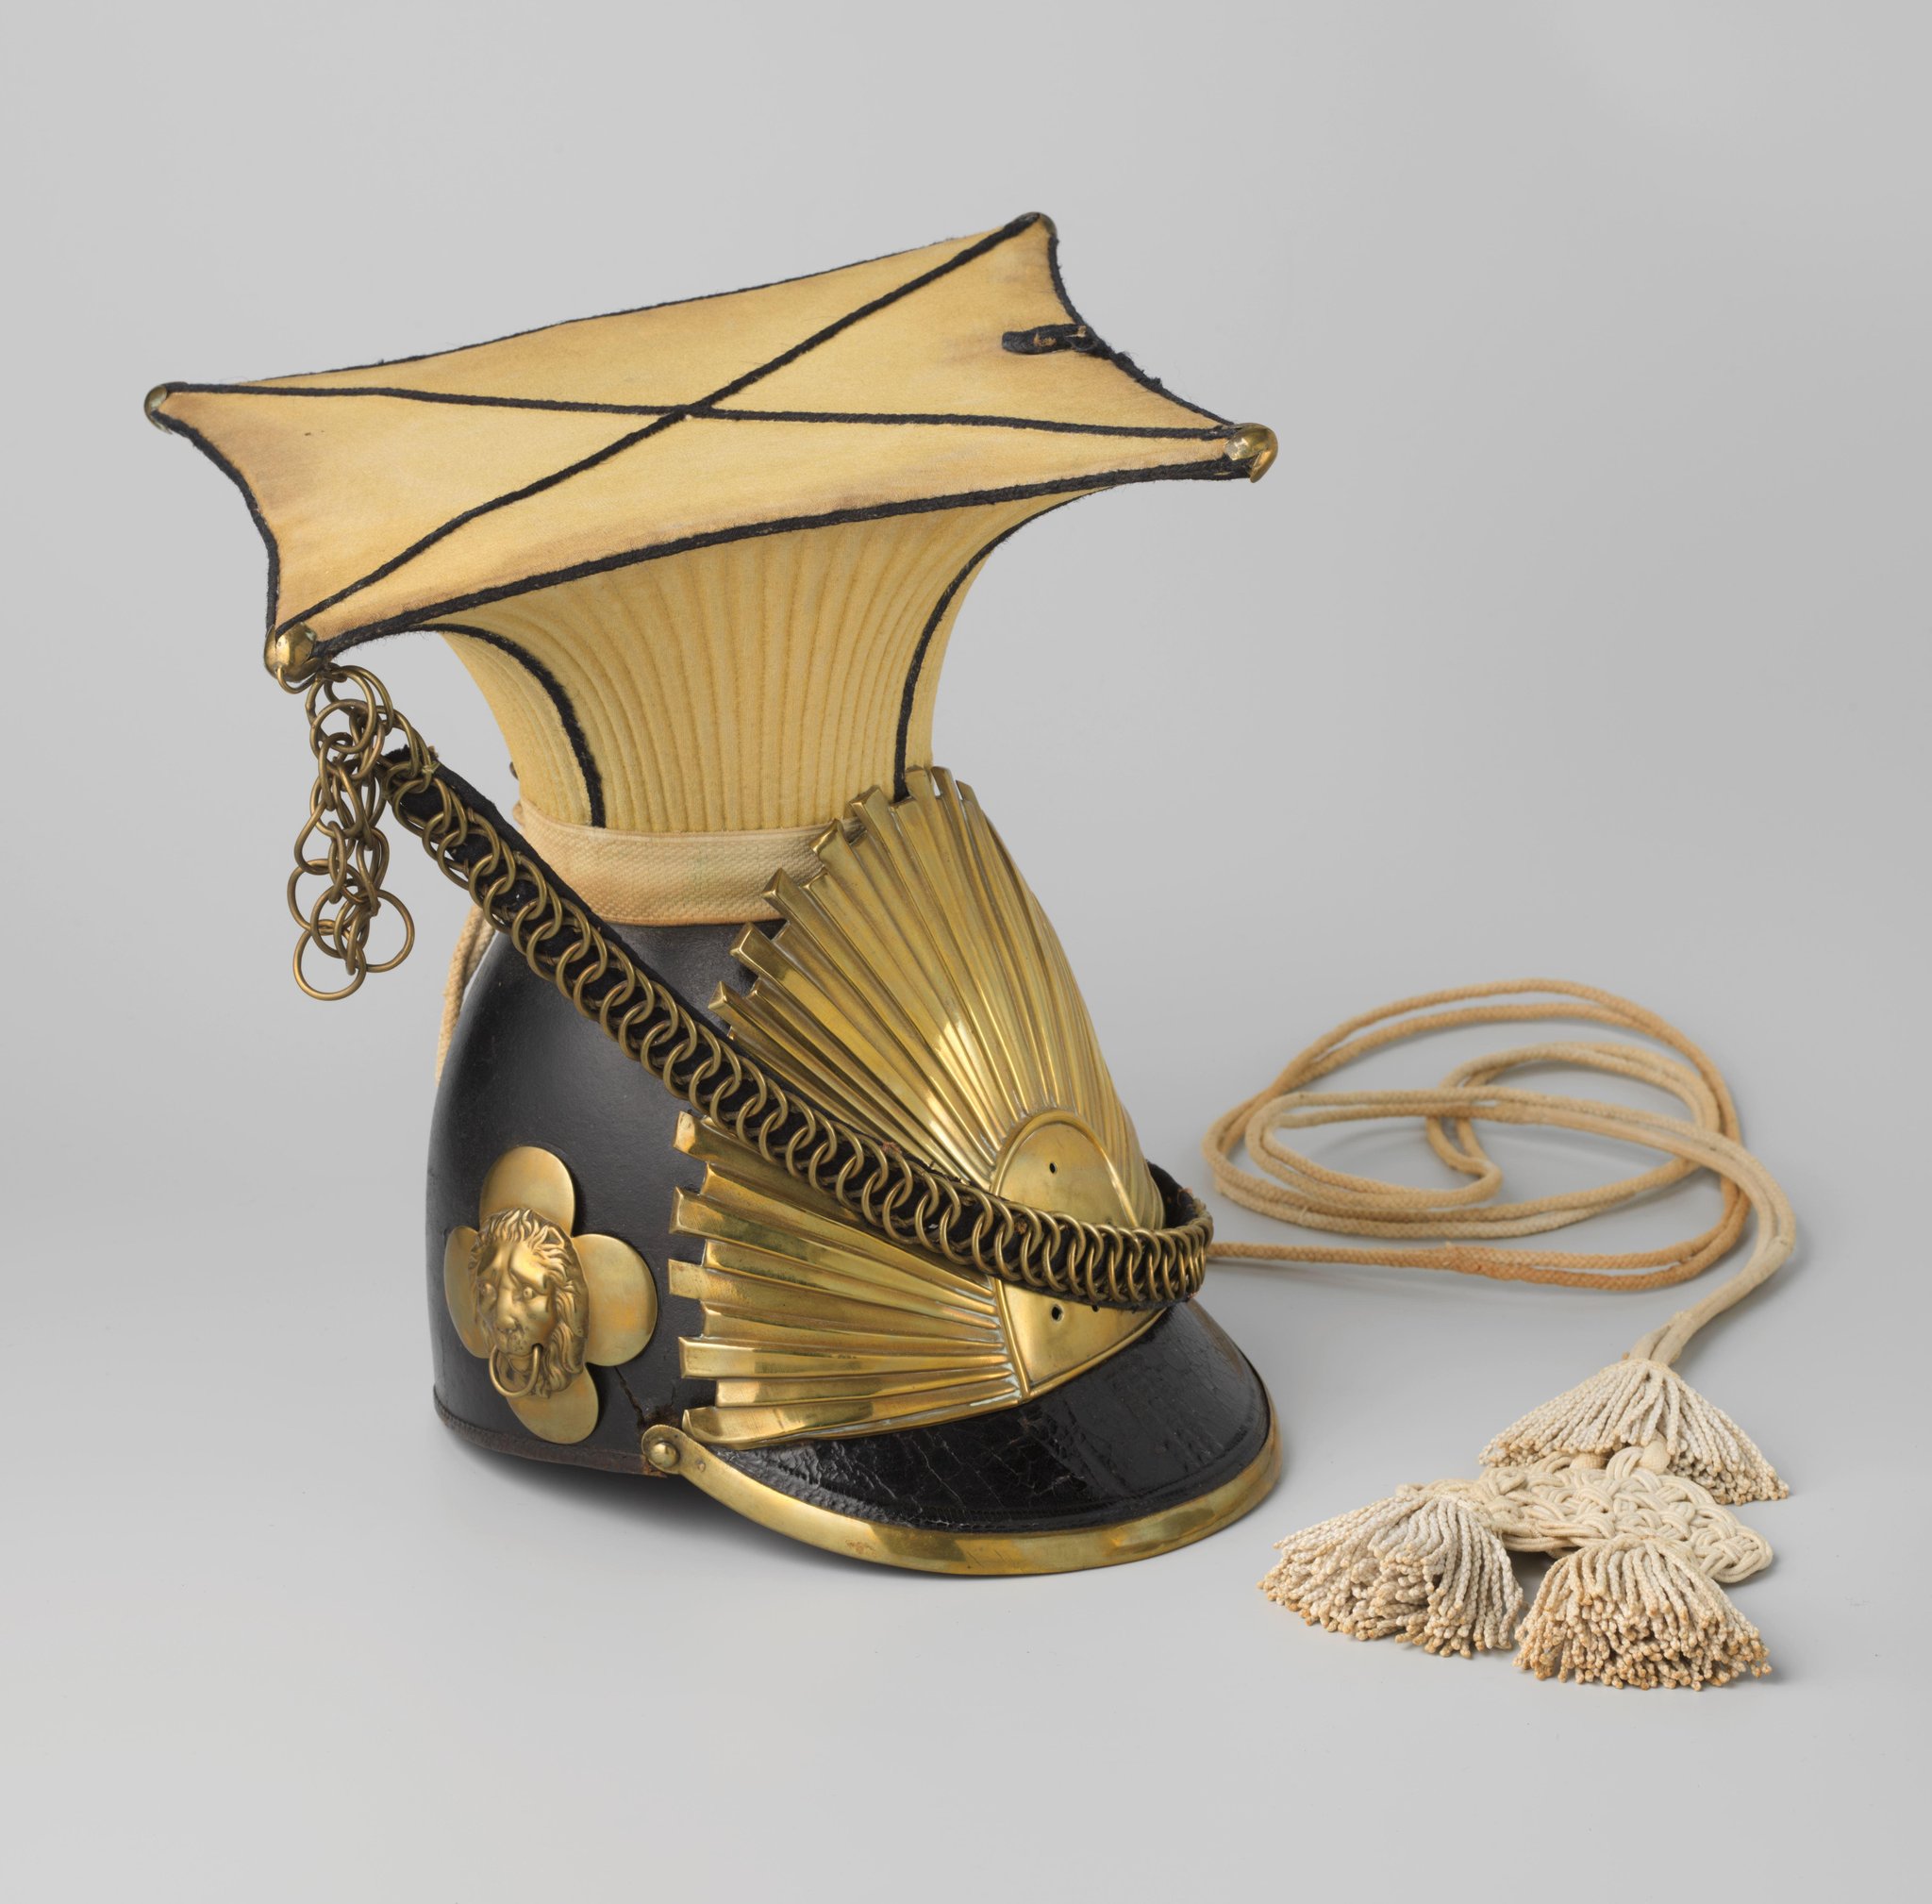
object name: hoofddeksel, hoofdbedekking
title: Tsjapka van eerste of tweede regiment lansiers, M. 1841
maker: Anonymous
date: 1841-1849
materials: brass, leather, linen, wool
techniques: painted, stitching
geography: netherlands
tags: netherlands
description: Hoofddeksel van zwart leren bol, klep, met geel metalen rand. Geel metalen zon, rozetten, kinketting (van sjako M.1865: zie kleine schakels), wit linnen bodem (later groen geverfd). Geel metalen hoeken, oranje wollen kokarde, biezen. Binnenwerk: bruin leren zweetband, linnen voering.